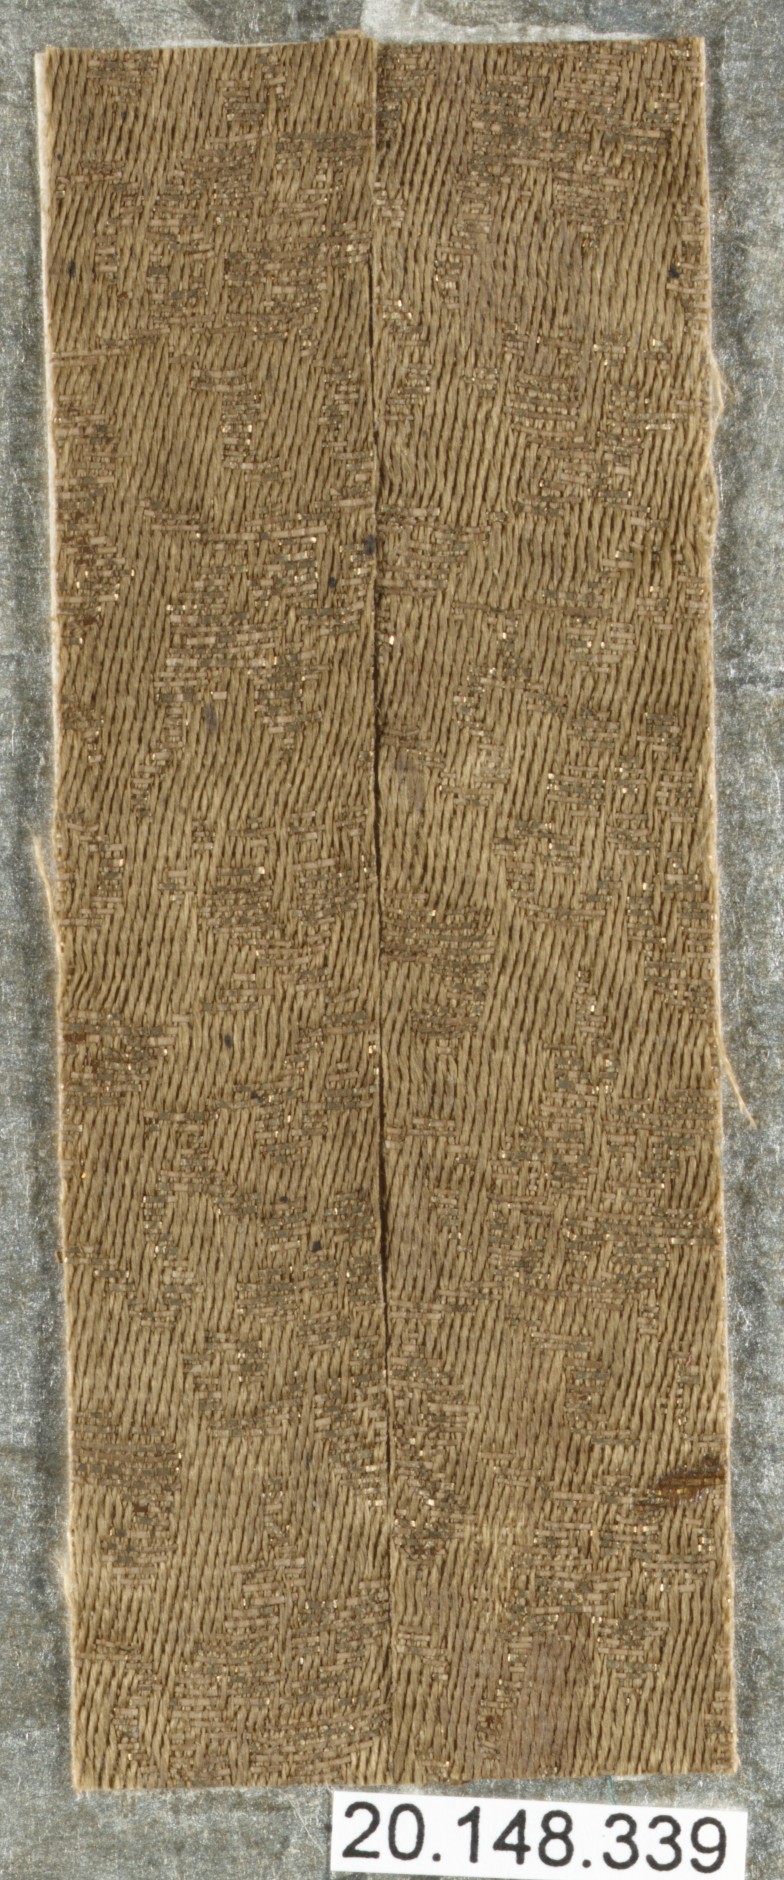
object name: piece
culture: japanese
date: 1601-1700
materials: silk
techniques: compound weave